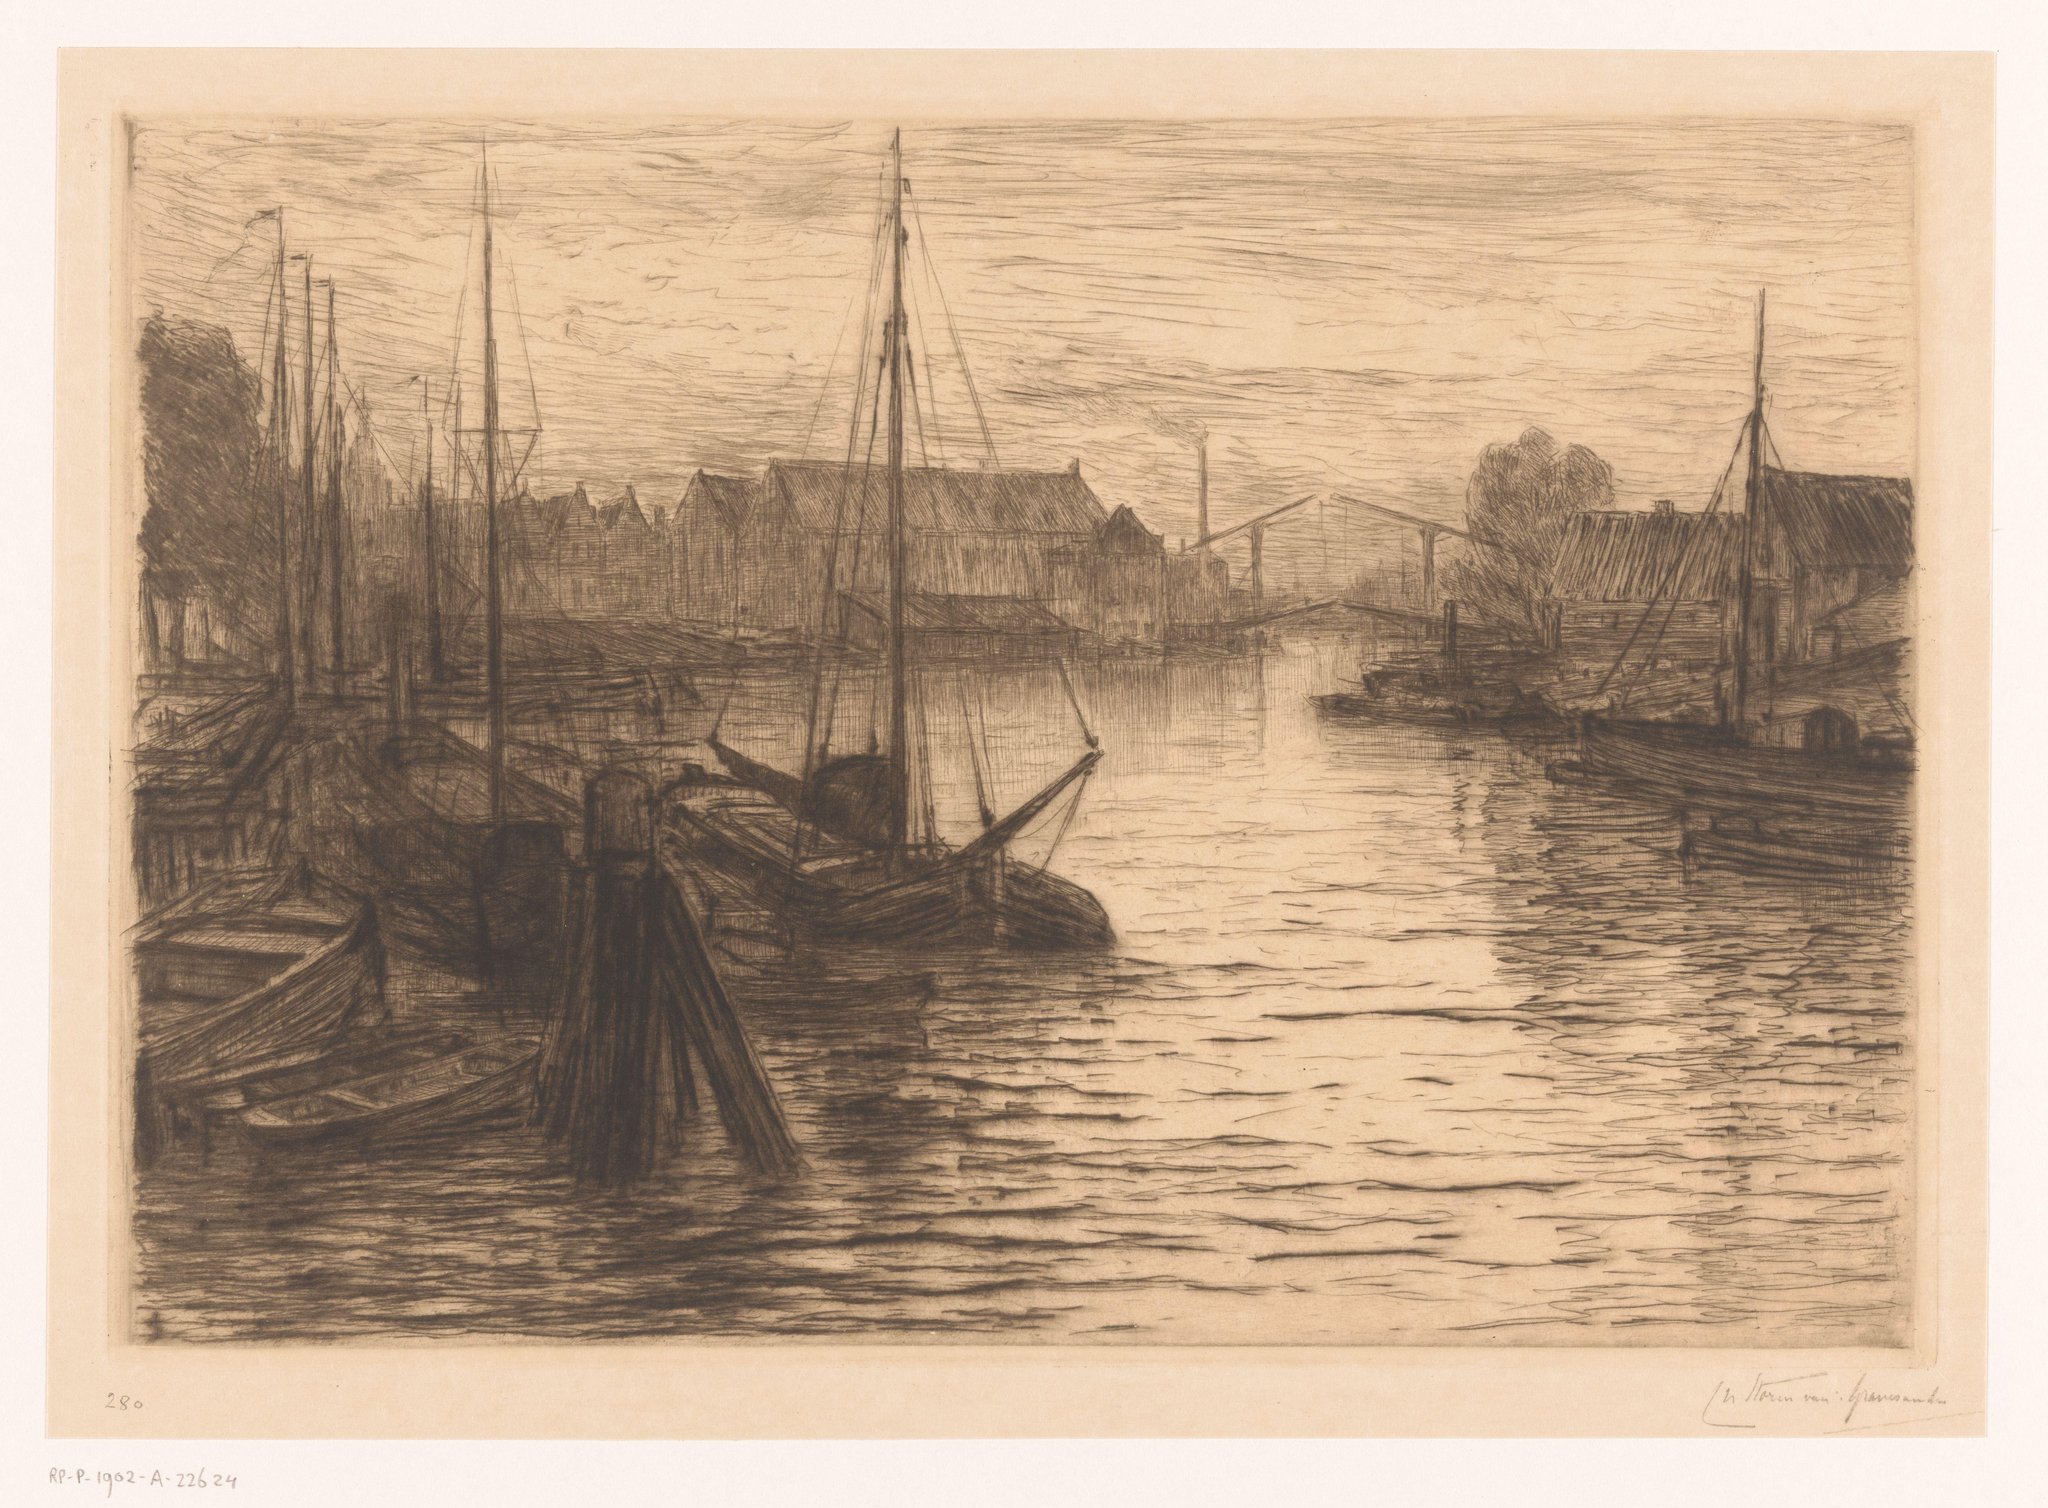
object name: print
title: Riedijkshaven in Dordrecht bij avond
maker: carel nicolaas storm van s-gravesande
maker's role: draughtsman, print maker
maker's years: 1841-1924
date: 1887-1889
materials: paper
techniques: drypoint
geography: netherlands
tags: harbour, evening, dordrecht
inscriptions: number: ‘280’, collector's mark: Lugt 2228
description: Mogelijk ook vermeld in: Storm van 's-Gravesande, Charles. Catalogue des eaux-fortes et lithographies. New York: s.n., 1903, of in een onbekende latere uitgave van het manuscript. Vermoedelijk vermeld als catalogusnummer 280.